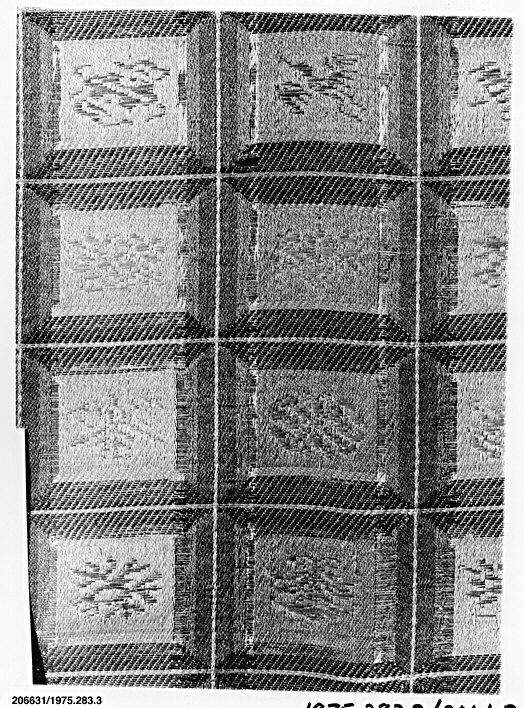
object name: case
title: Padded Case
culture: japanese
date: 1801-1900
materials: gold, textile, silk